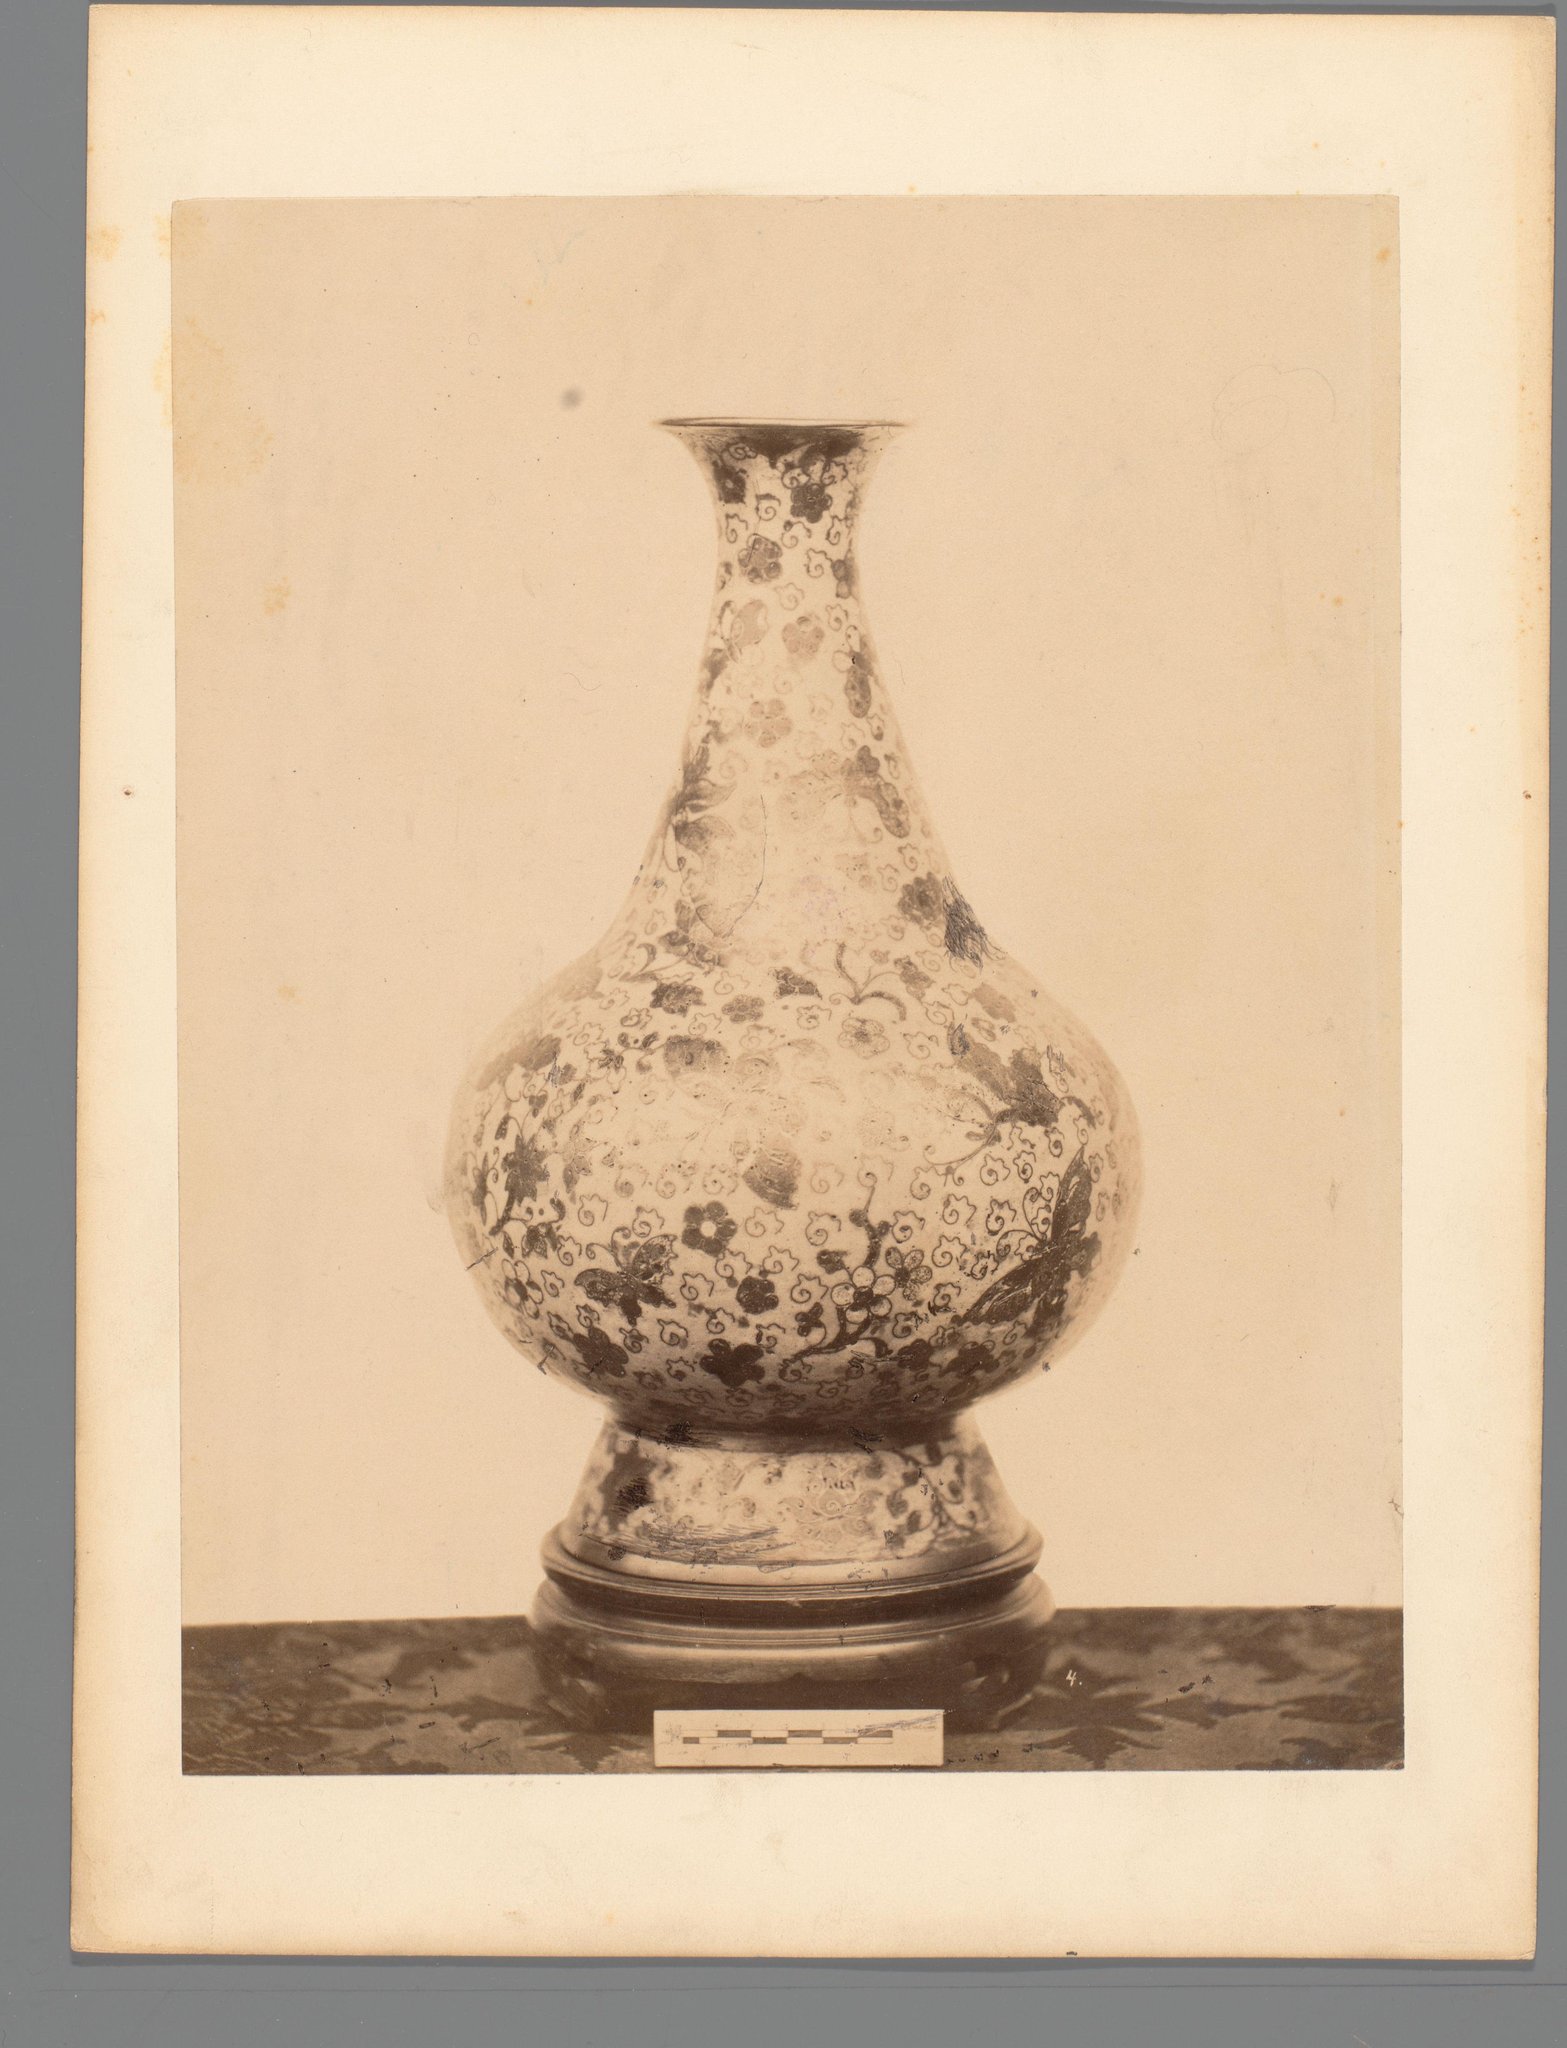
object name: photograph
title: Vaas gedecoreerd met bloemmotief en vlinders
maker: Anonymous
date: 1875-1900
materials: cardboard, photographic support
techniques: albumen print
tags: insects: butterfly, container of ceramics: jar, jug, pot, vase, ornamenting, decorating ~ applied arts, flowers ~ ornament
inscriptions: collector's mark: Lugt 3937, number: ‘4.’